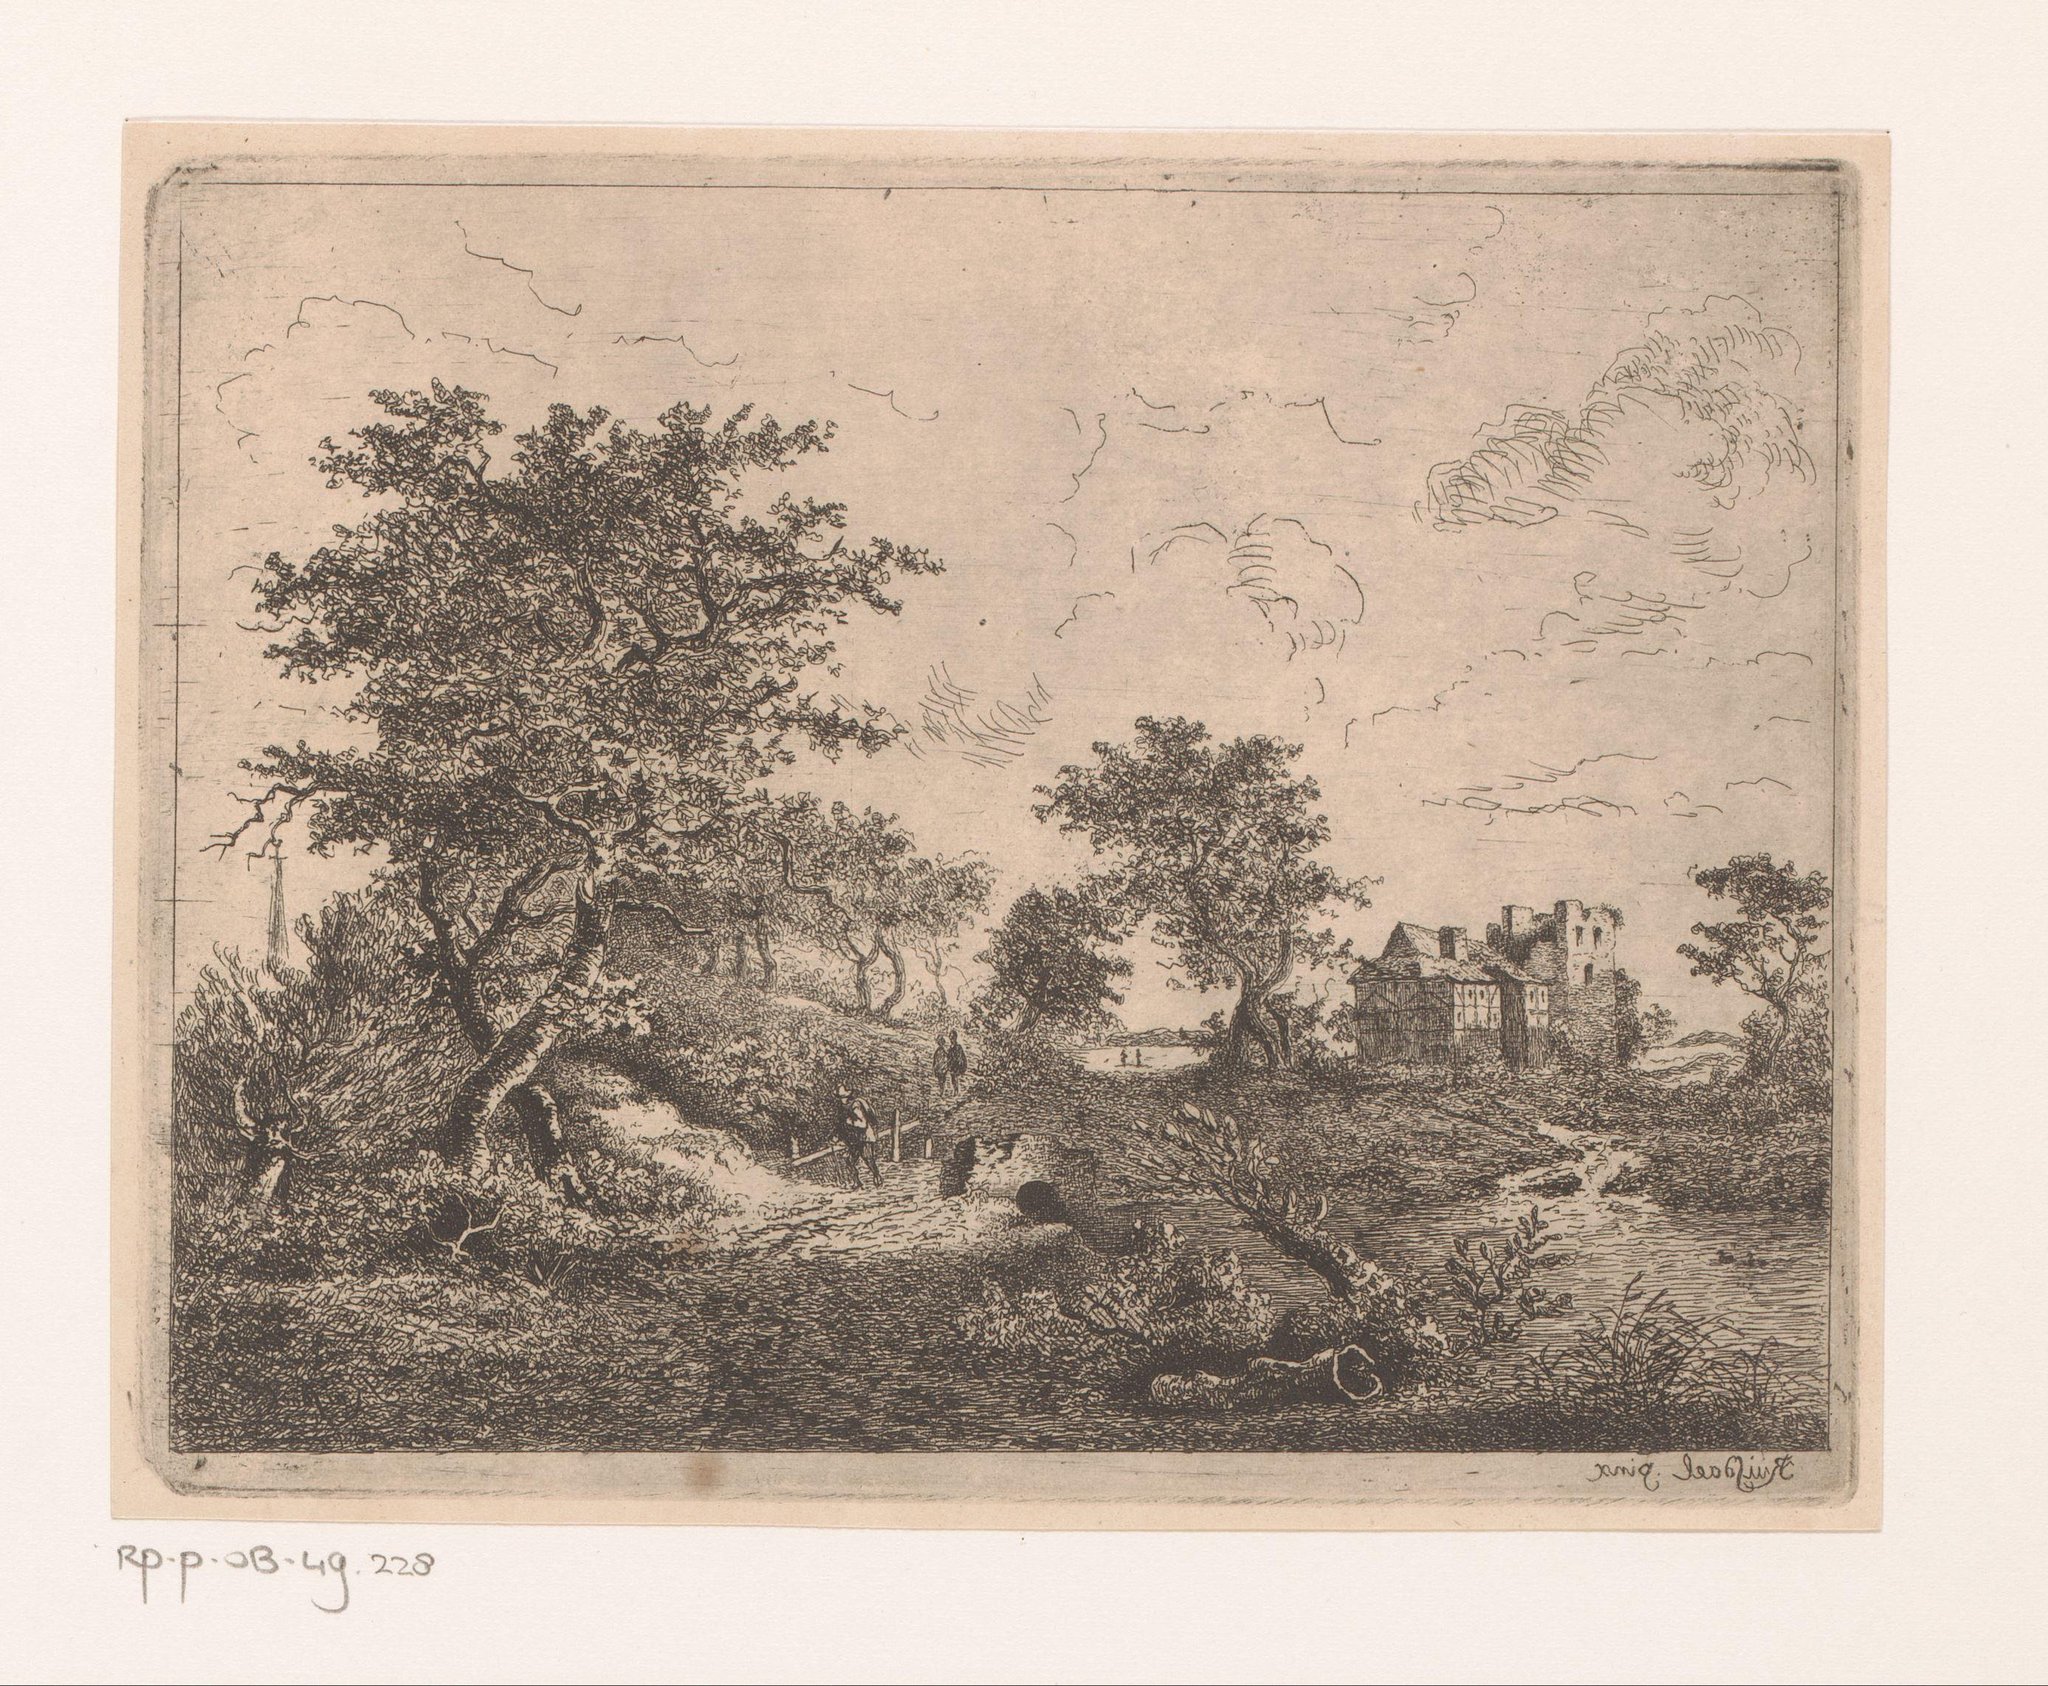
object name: print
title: Landschap met lage brug over een stroom en een vervallen landhuis op de achtergrond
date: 1825-1891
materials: paper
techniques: etching, intaglio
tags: river, ruin of a dwelling, house, castle, etc.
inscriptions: collector's mark: Lugt 2228